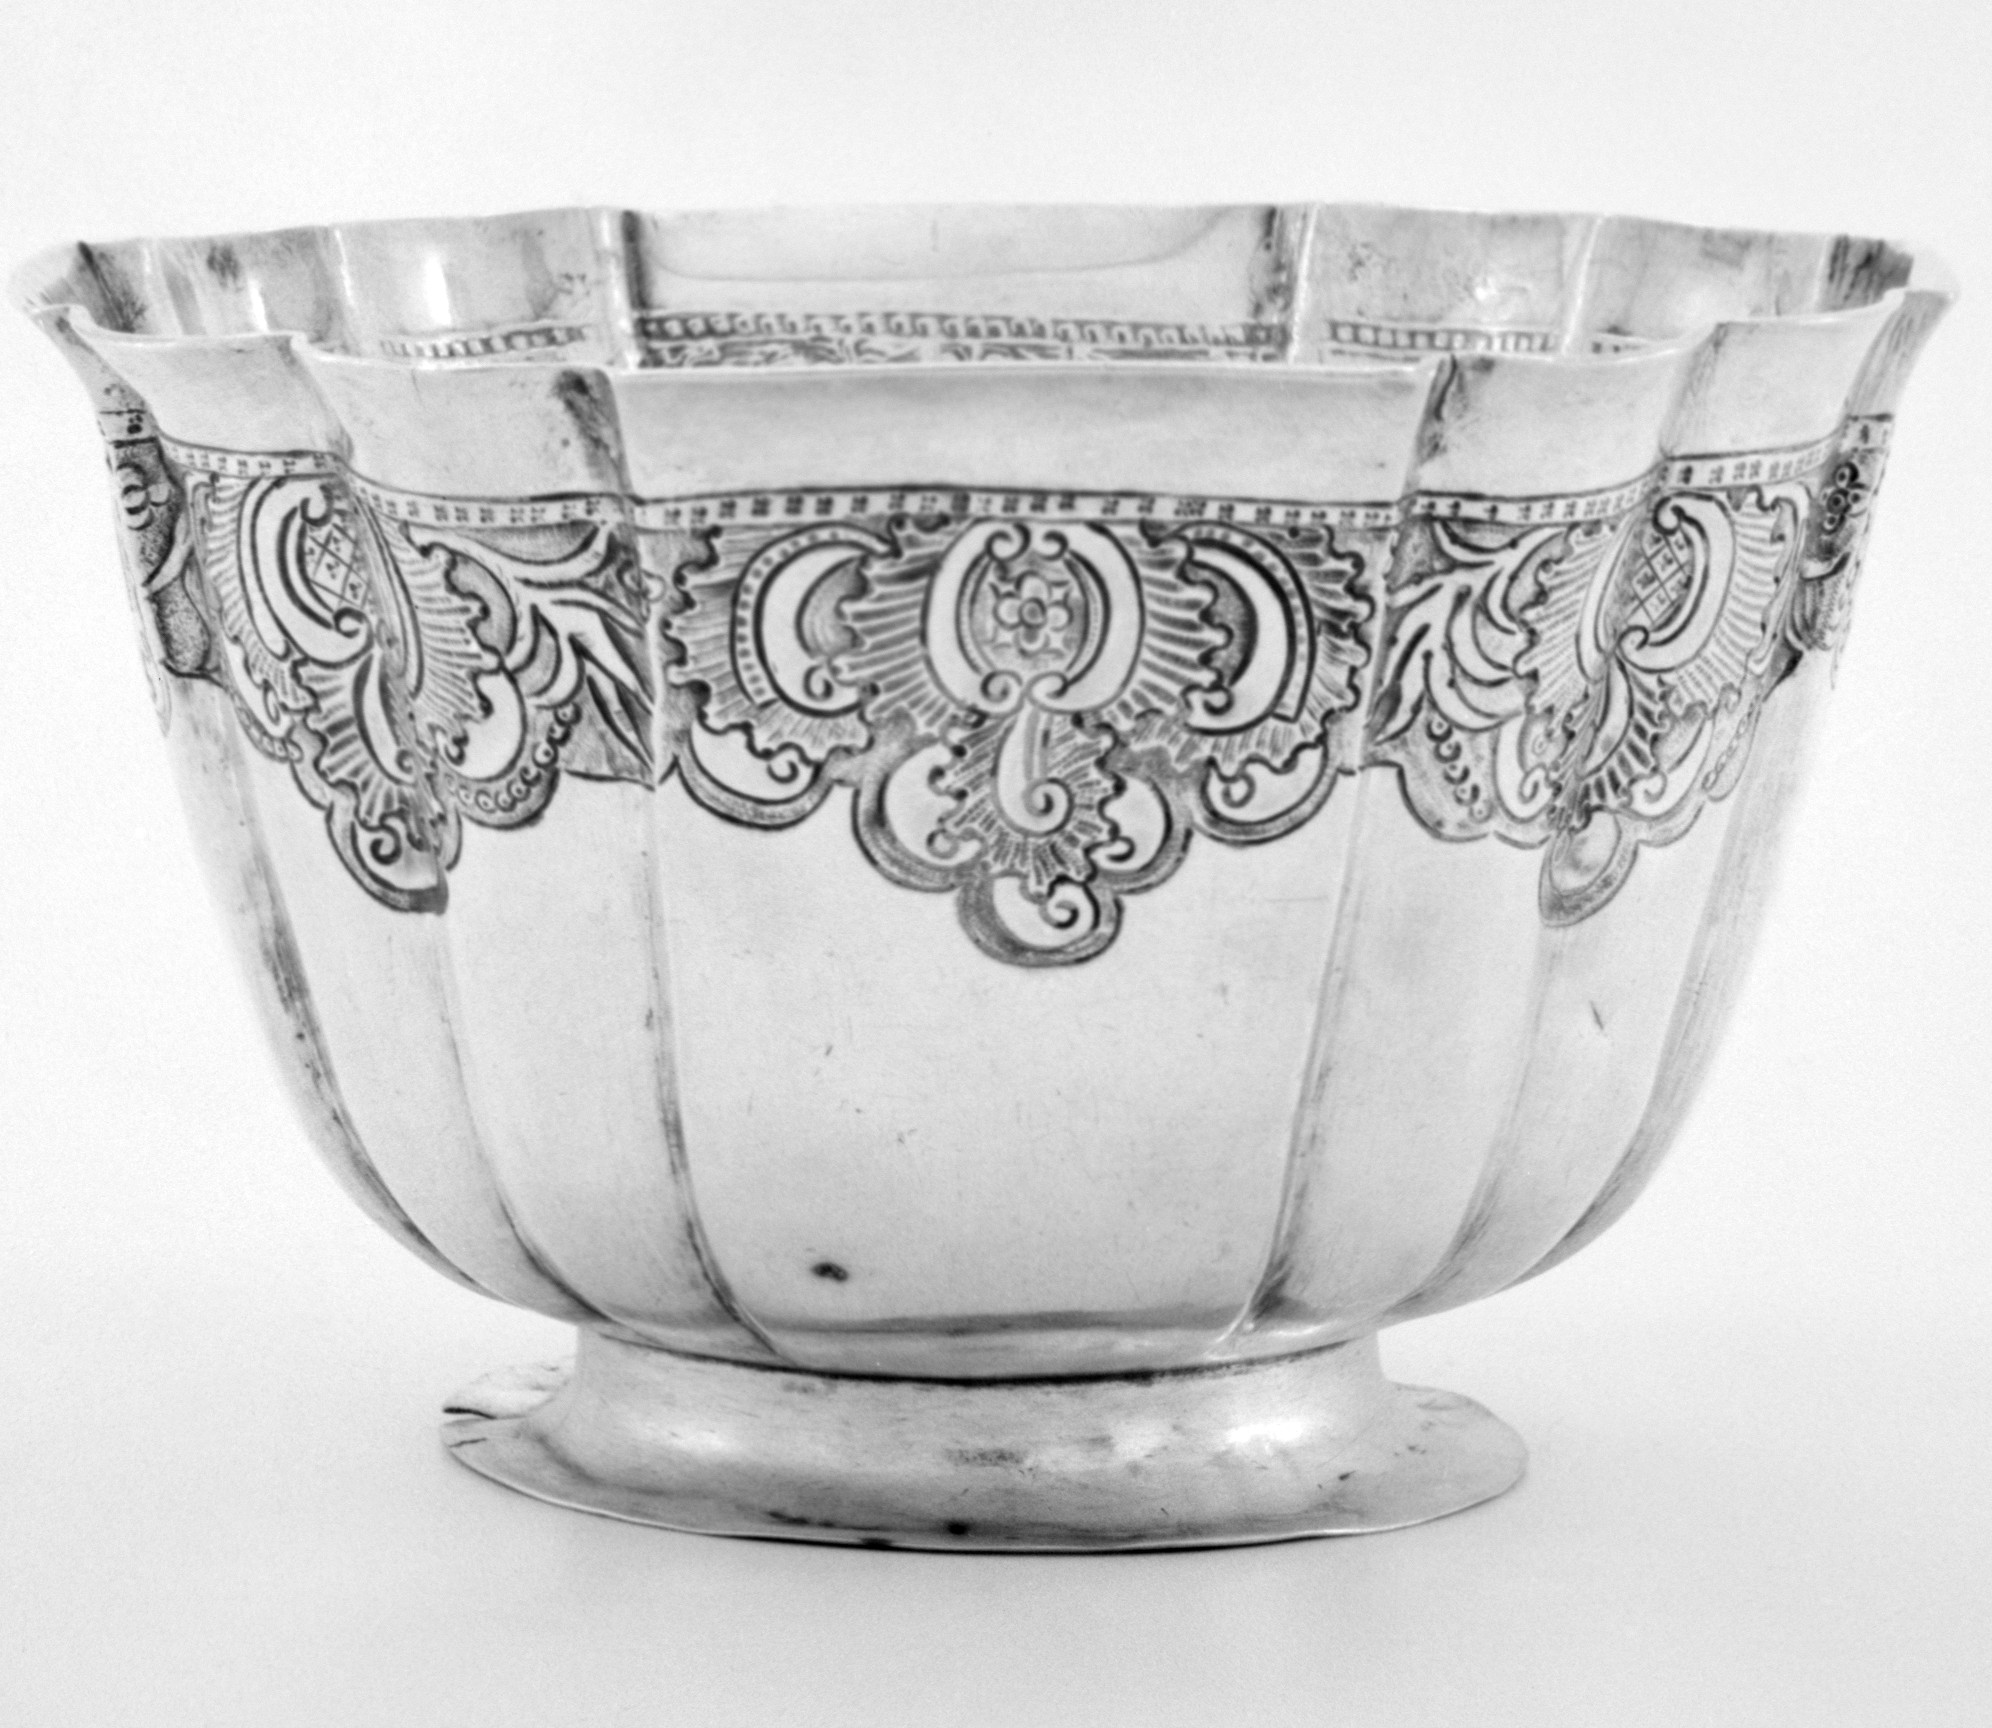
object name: bowl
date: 1750-1760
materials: silver